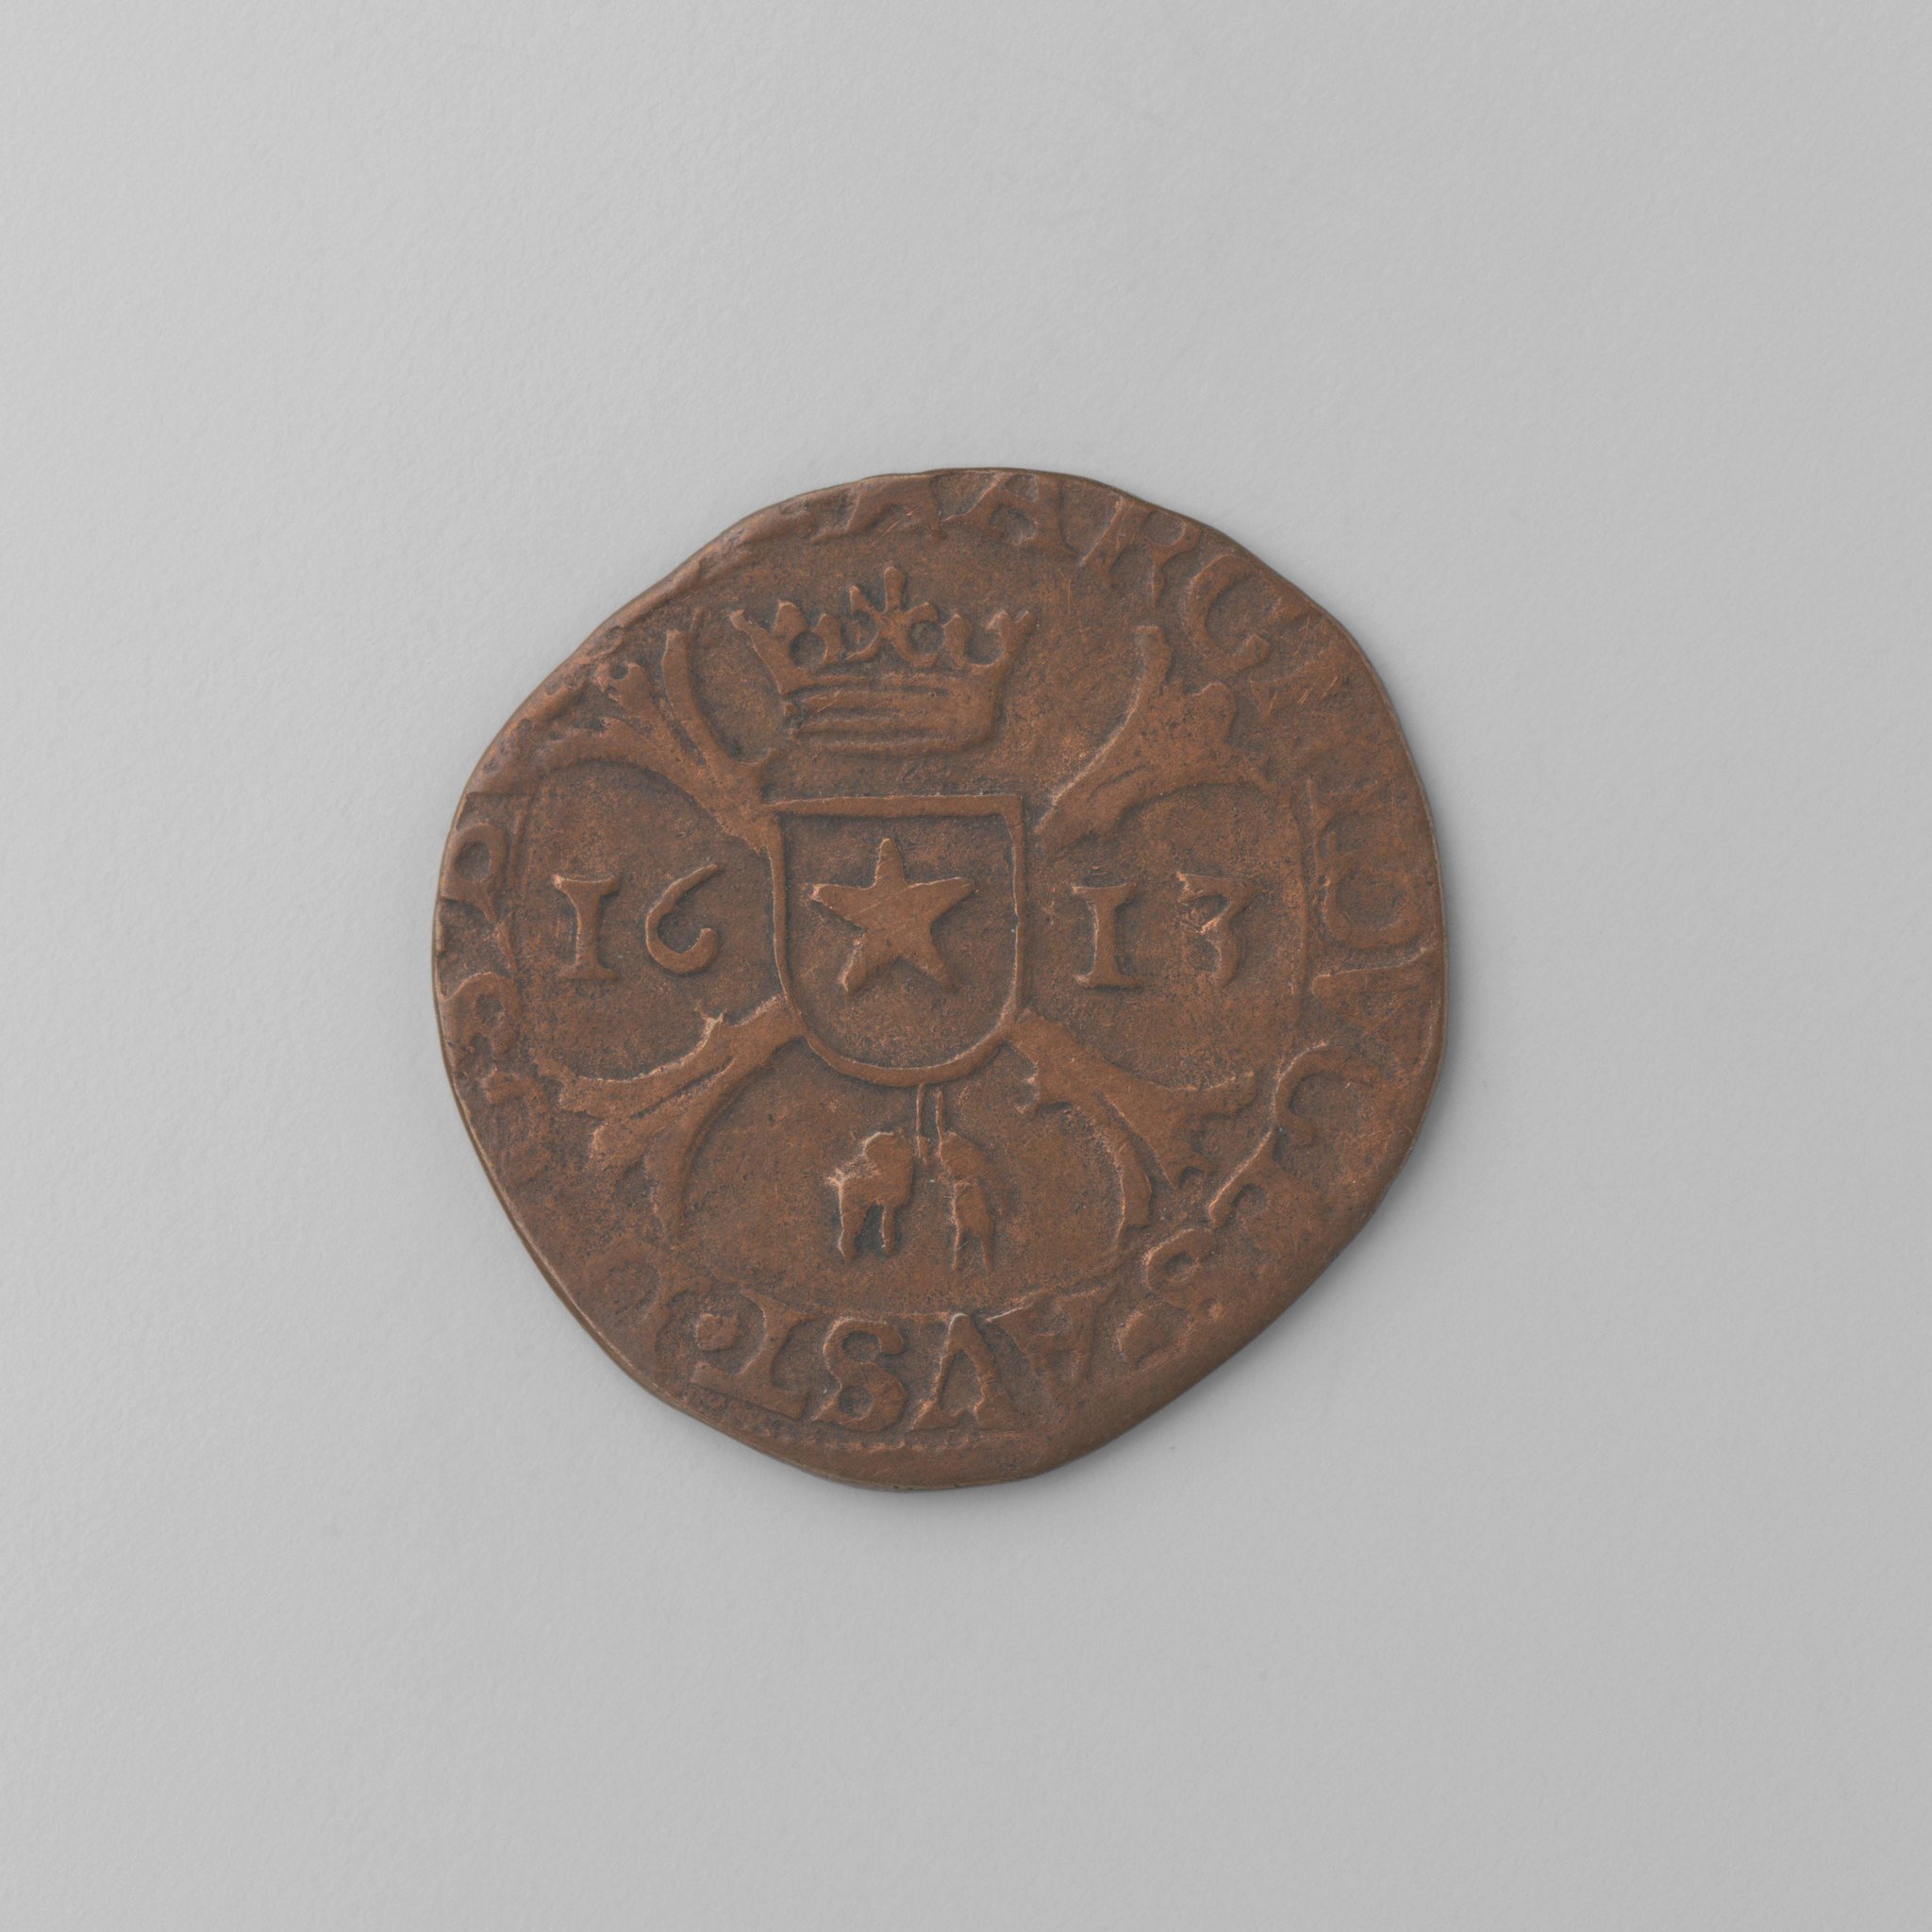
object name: oord, oortje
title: Oord van aartshertogen Albert en Isabella, hertogen van Brabant, 1613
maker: hertog van brabant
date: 1613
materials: copper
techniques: striking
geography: maastricht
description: Koperen munt. Voorzijde: tussen sterren [=munttekens van Maastricht] gekroond wapenschild. Keerzijde: tussen jaartal op stokkenkruis gekroond wapenschild van Maastricht, waaronder het Gulden Vlies.